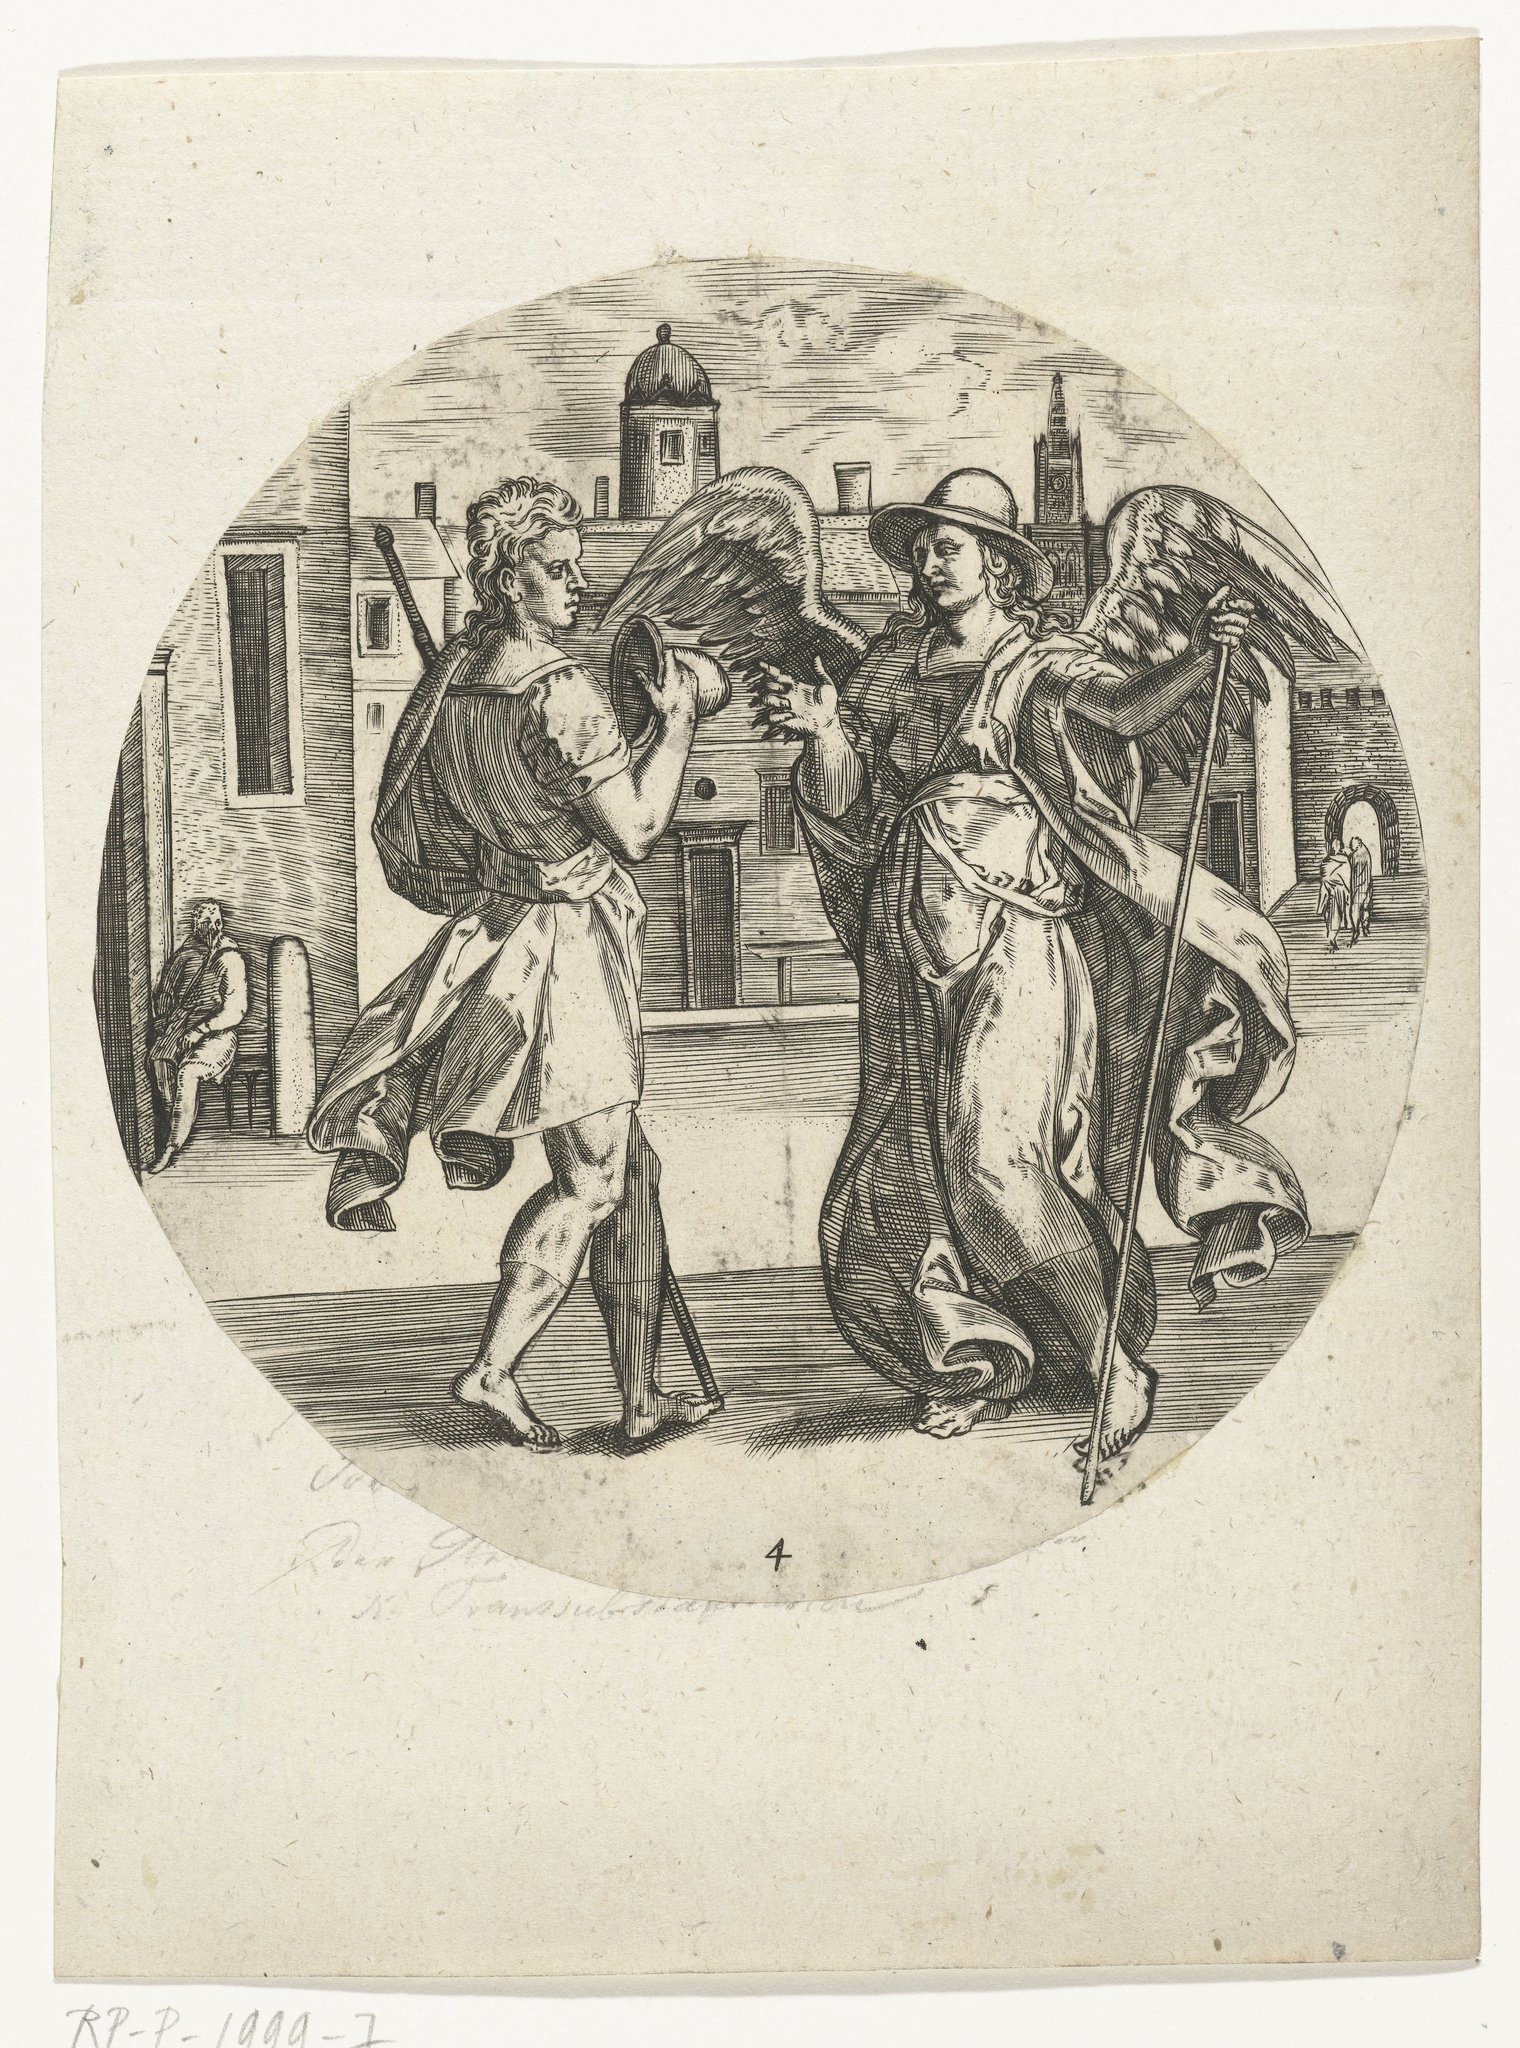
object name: print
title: Ontmoeting van Tobias en engel Rafael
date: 1570-1580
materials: paper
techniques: engraving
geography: netherlands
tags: the meeting of tobias and the angel raphael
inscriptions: collector's mark: Lugt 919 bis, collector's mark: Lugt 2760, collector's mark: Lugt 2228, collector's mark: Lugt 847a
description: Prent uit serie van twaalf prenten op rond formaat met het verhaal van Tobias.